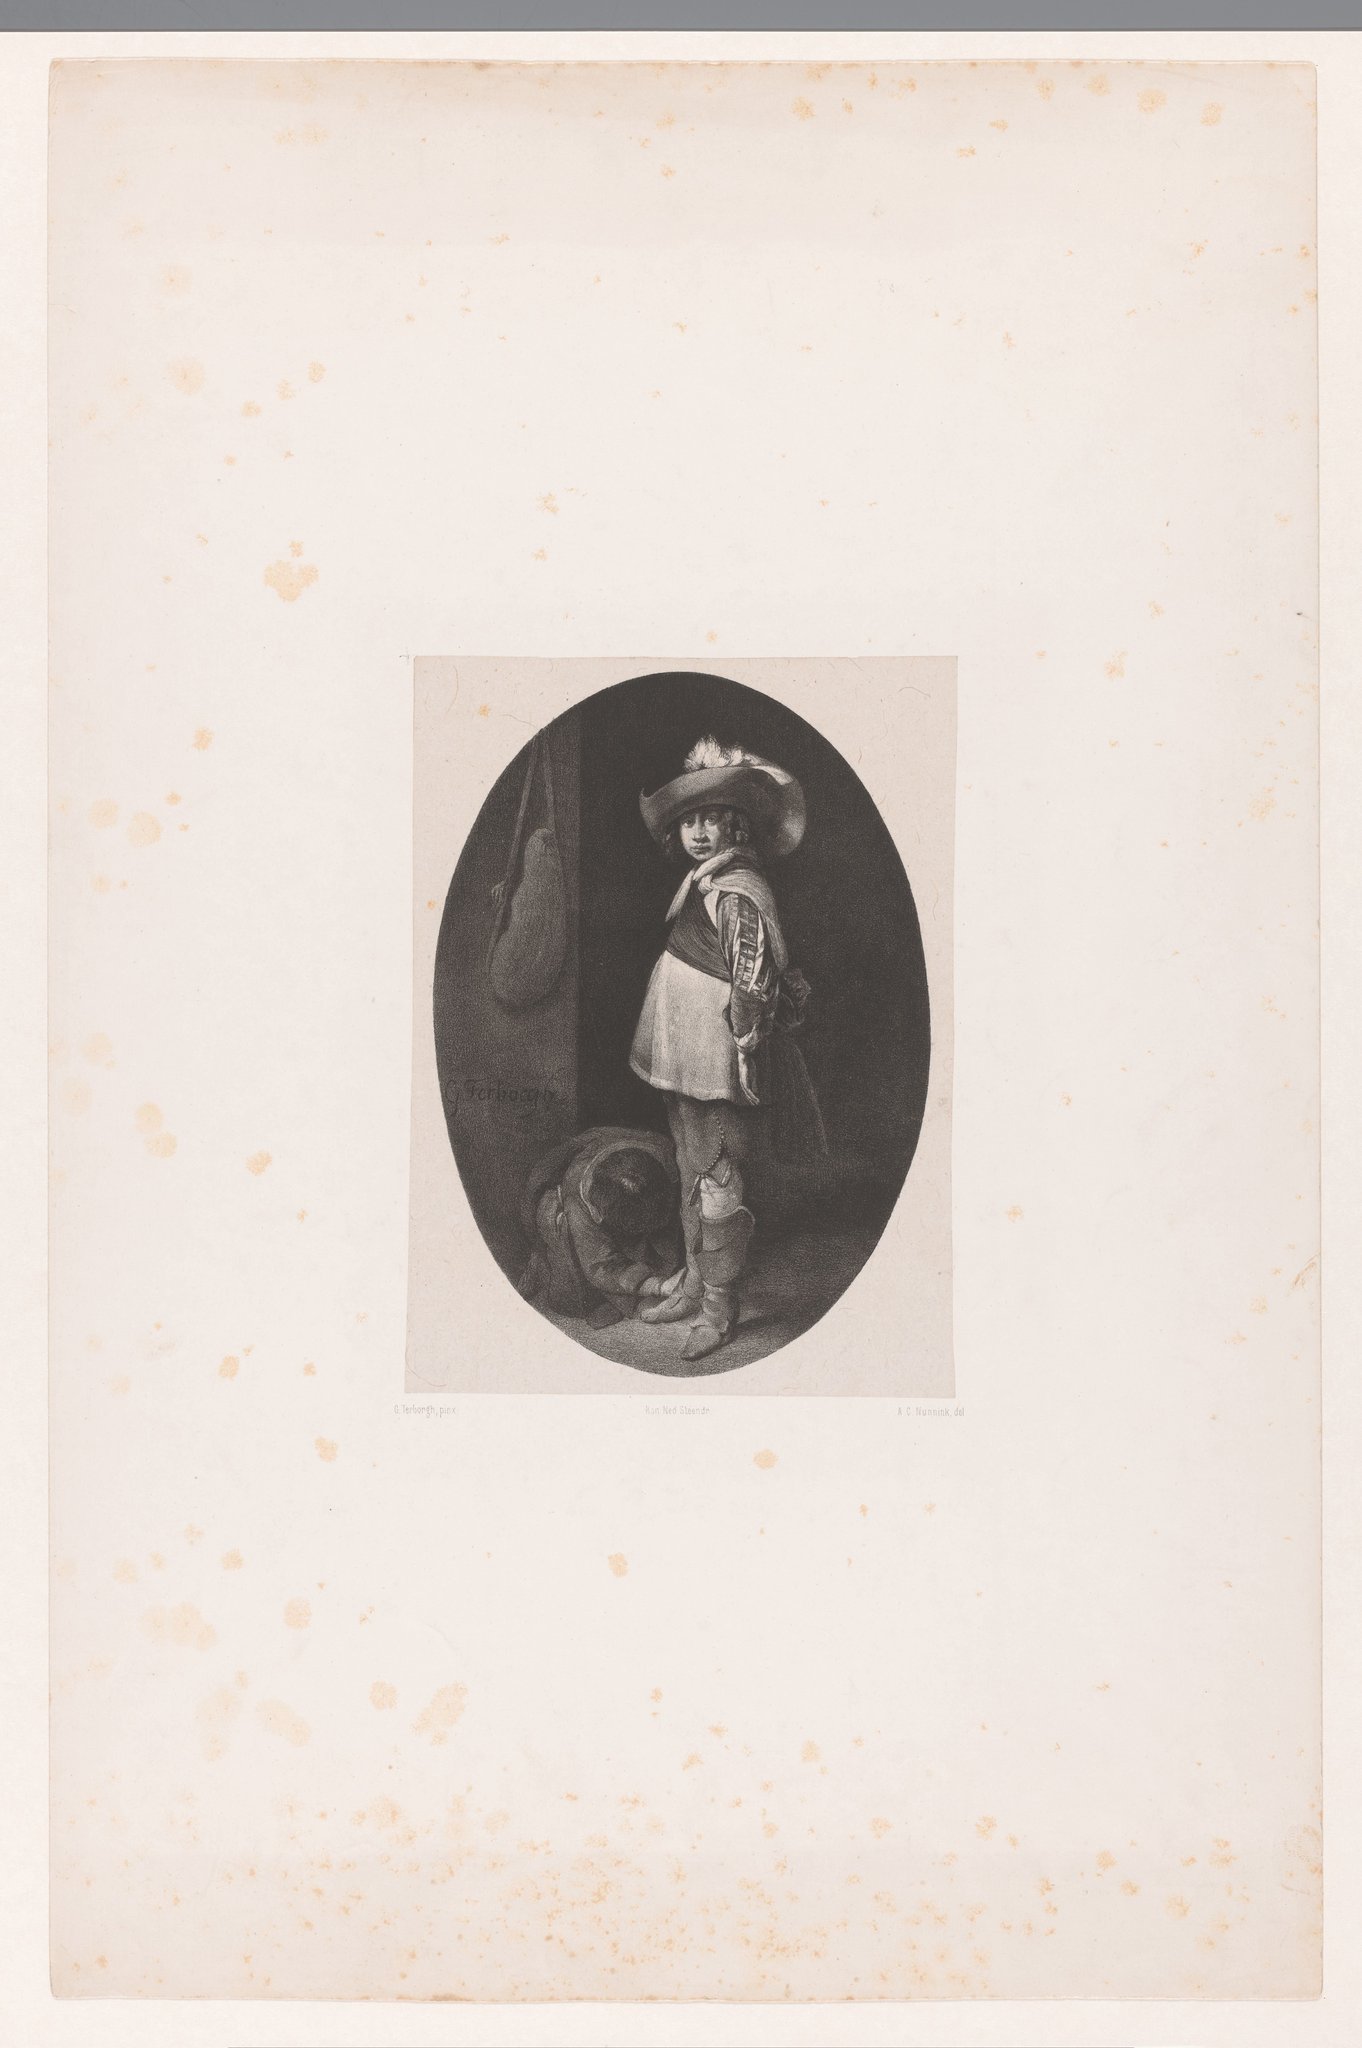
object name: print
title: Jongen met hoed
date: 1867-1874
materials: paper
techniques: lithograph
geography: the hague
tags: head-gear: hat, kneeling figure, child (at home)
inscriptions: collector's mark: Lugt 2228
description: Een jongen met hoed staat naast een op zijn knieën zittende jongen. Links hangt een zak. In een ovale lijst.